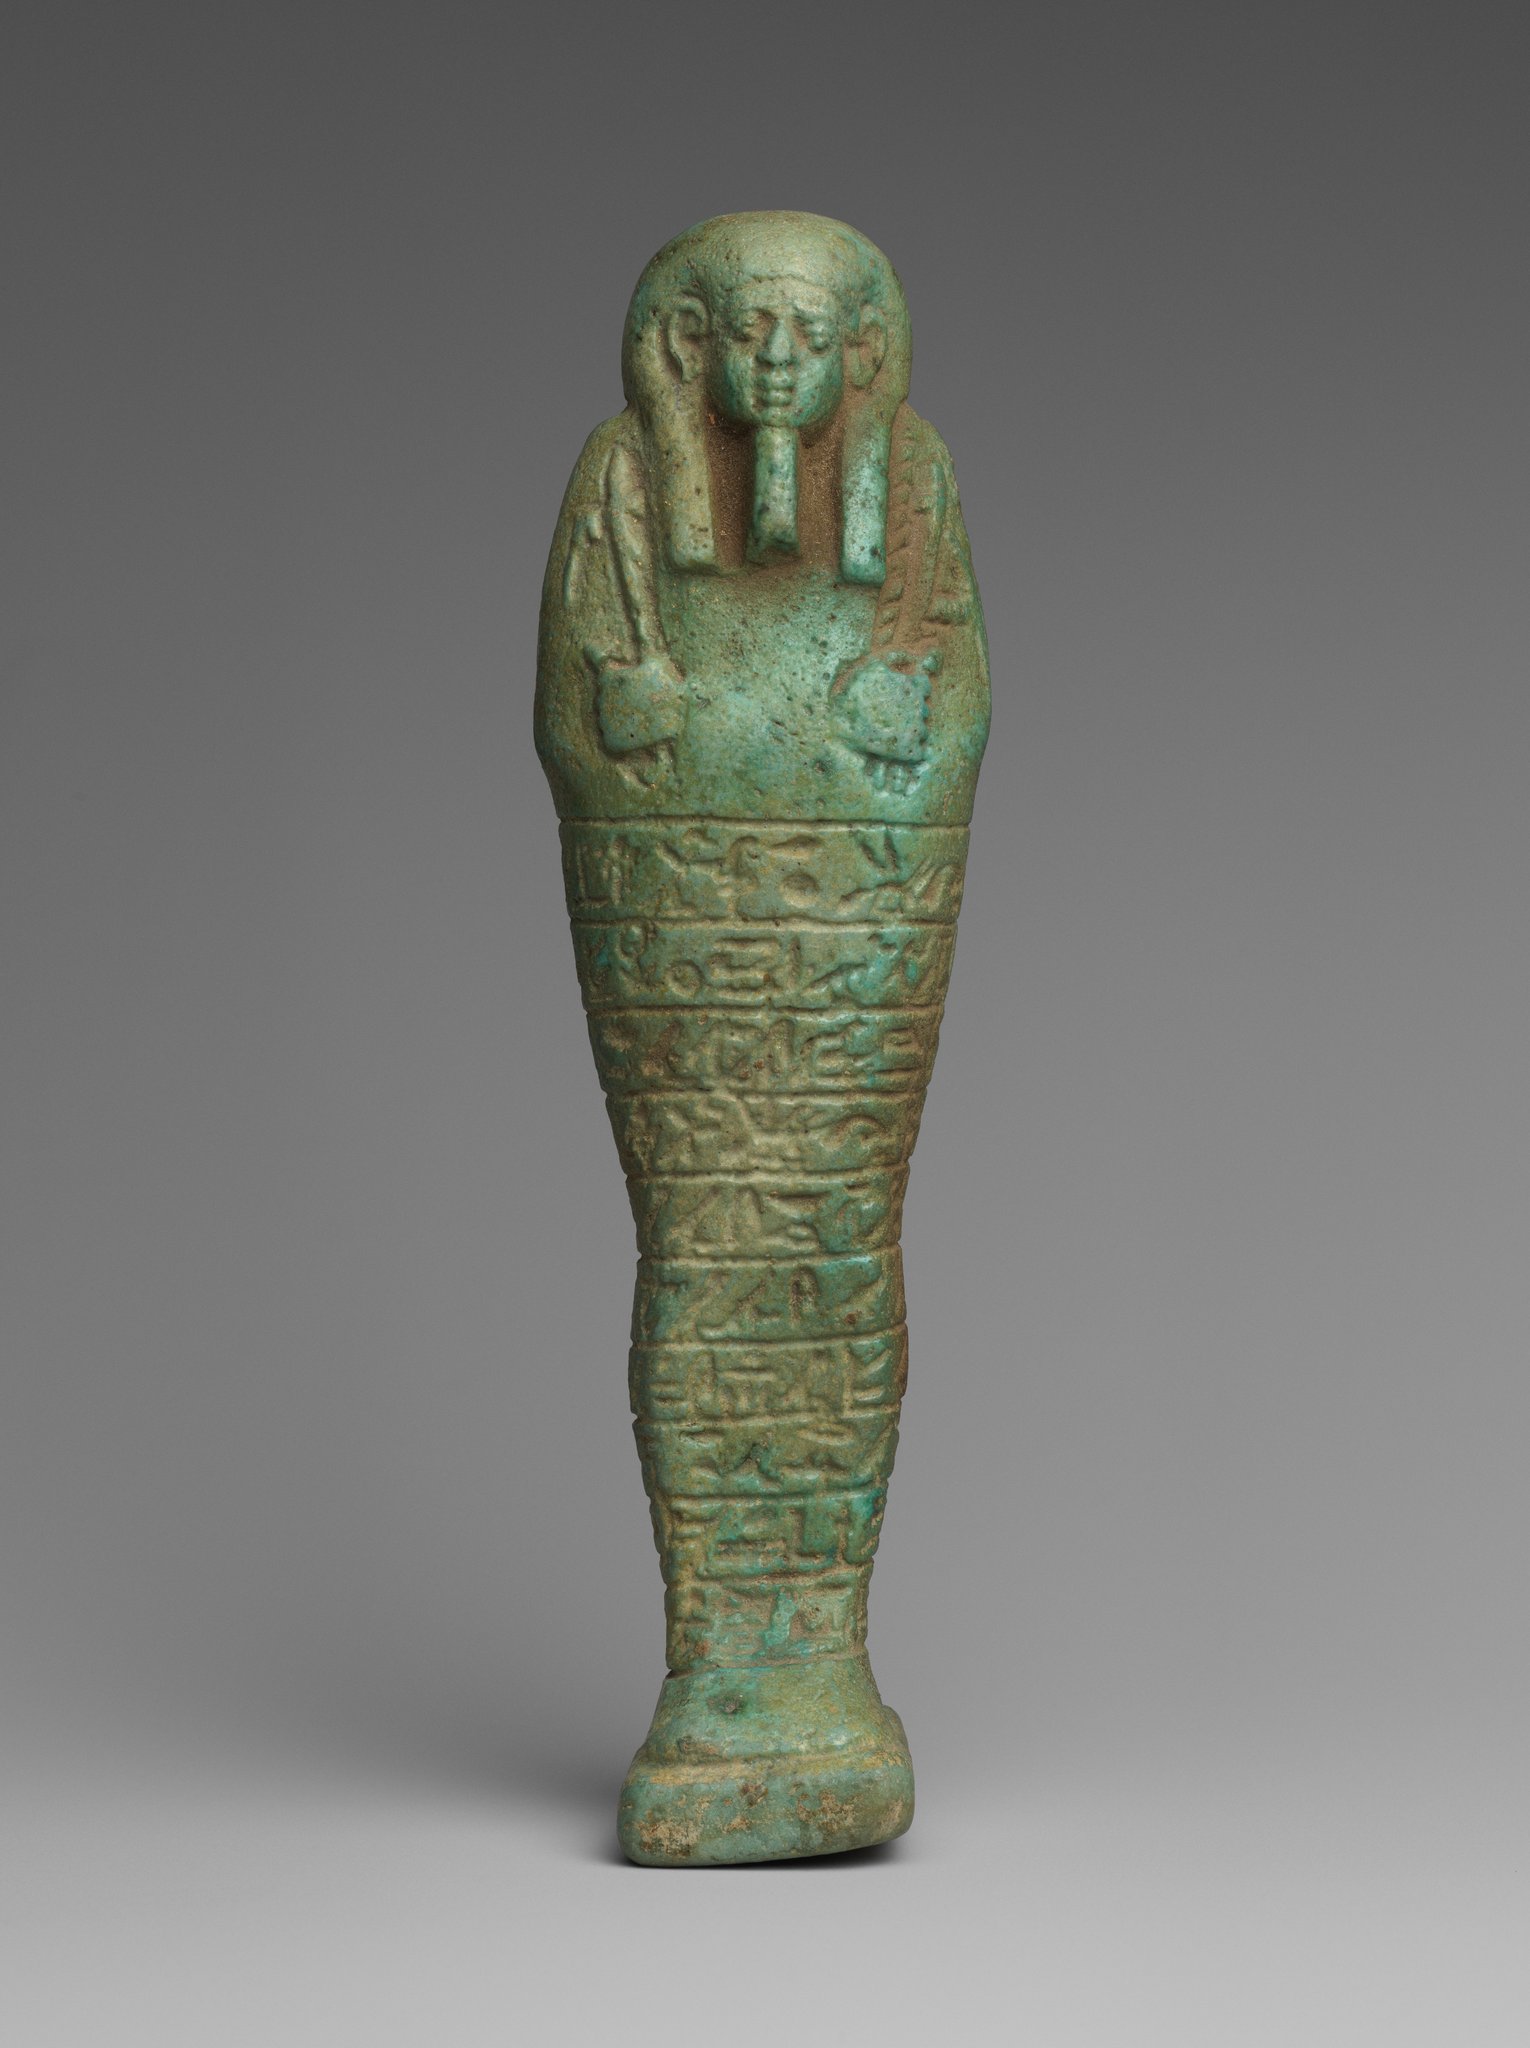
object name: shabti, pa abu meh, psamtik seneb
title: Shabti of the Treasurer of Lower Egypt Pa-abumeh, called Psamtik-seneb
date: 595-380 BCE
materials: faience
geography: egypt